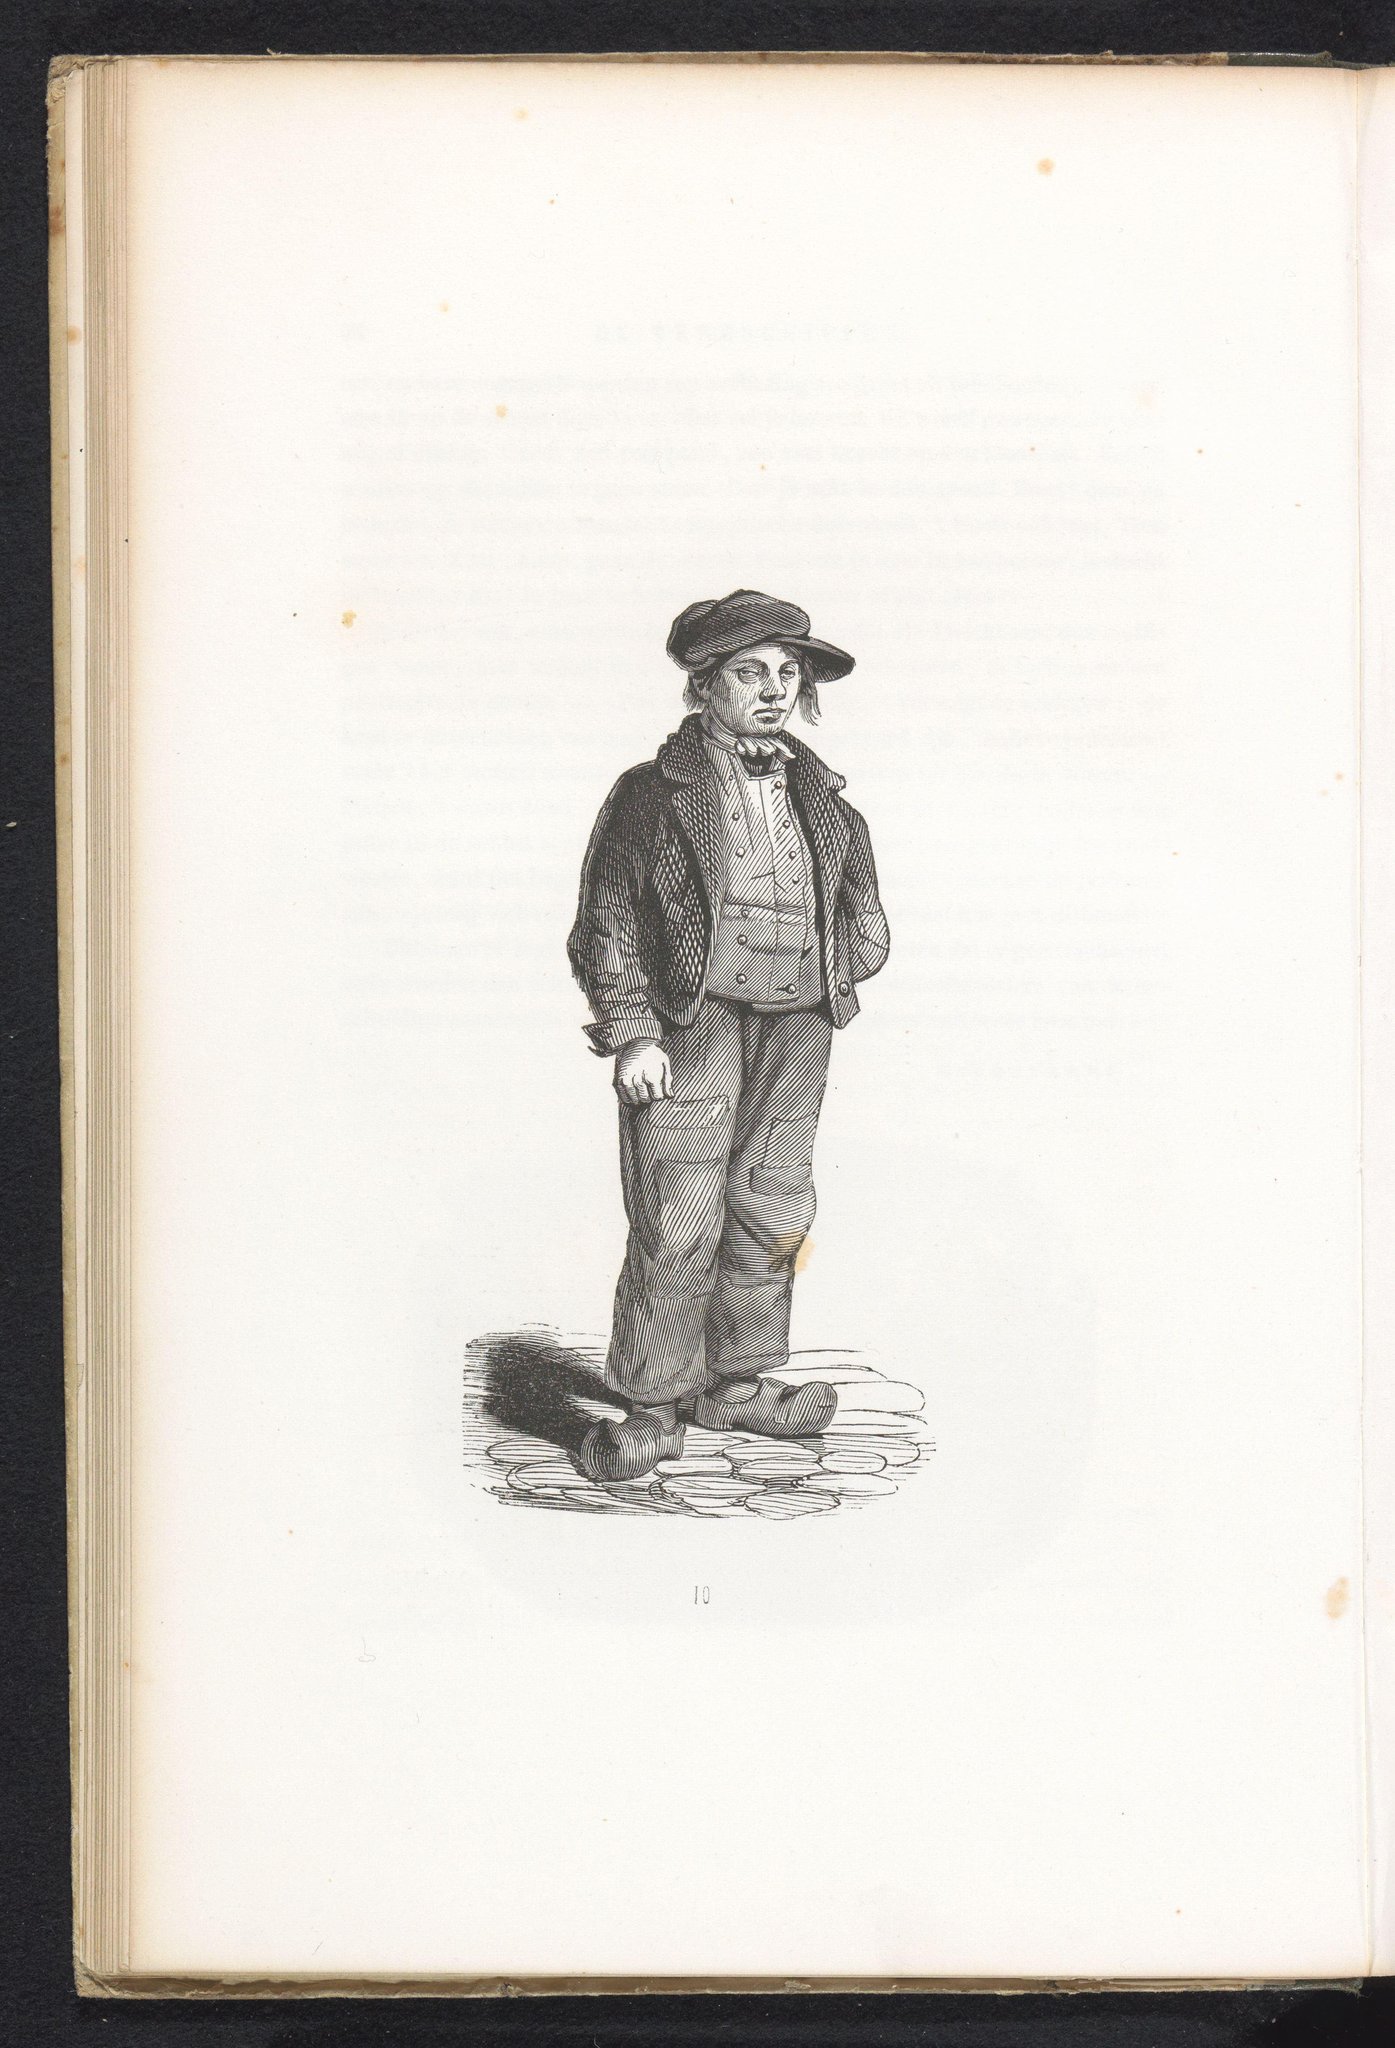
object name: print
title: De straatjongen, 1840-1841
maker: henry brown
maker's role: print maker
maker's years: 1816-1870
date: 1841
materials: paper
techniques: letterpress printing, engraving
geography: netherlands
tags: professional clothes, the poor, netherlands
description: De straatjongen. Staande jonge man. Genummerd: 10. Illustratie in het boek 'De Nederlanden: karakterschetsen, kleederdrachten, houding en voorkomen van verschillende standen', een boek met karakterschetsen, beroepen en klederdrachten van Nederlandse volkstypen uit 1841.